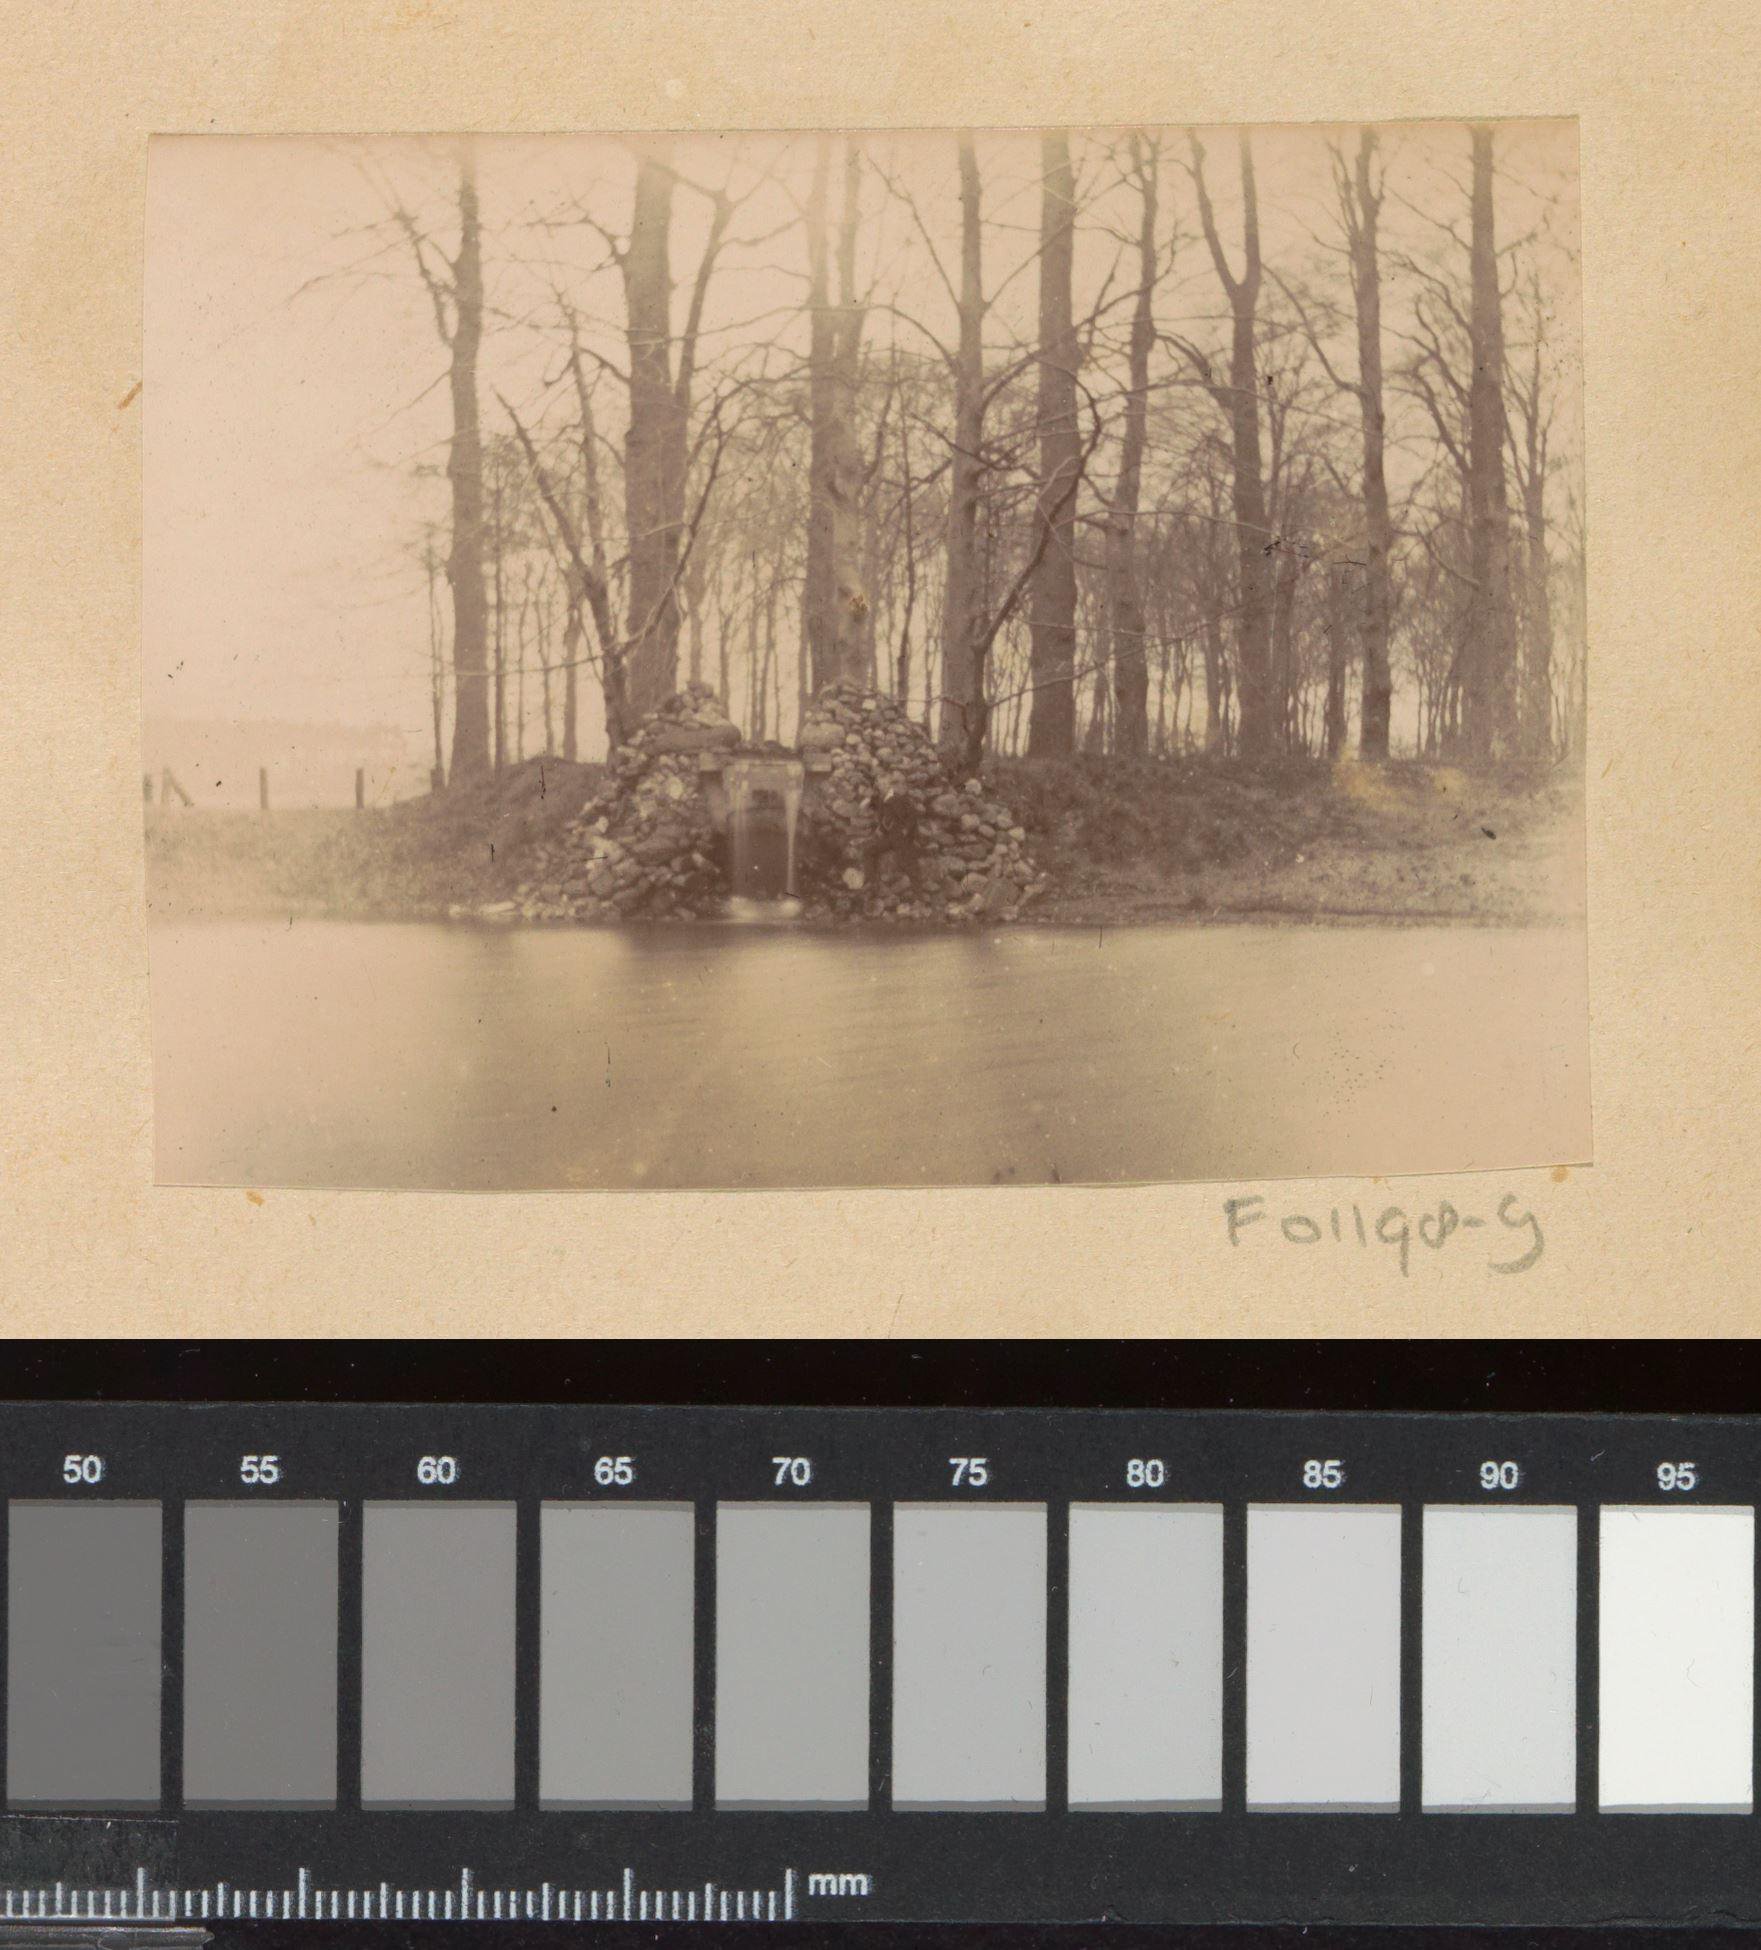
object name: album leaf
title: Kunstmatige waterval langs een rivier of meer, mogelijk in Arnhem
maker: johanna margaretha piek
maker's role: fotograaf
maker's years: 1870-1947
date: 1889-1893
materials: paper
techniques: gelatin silver print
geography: arnhem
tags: waterfall, arnhem